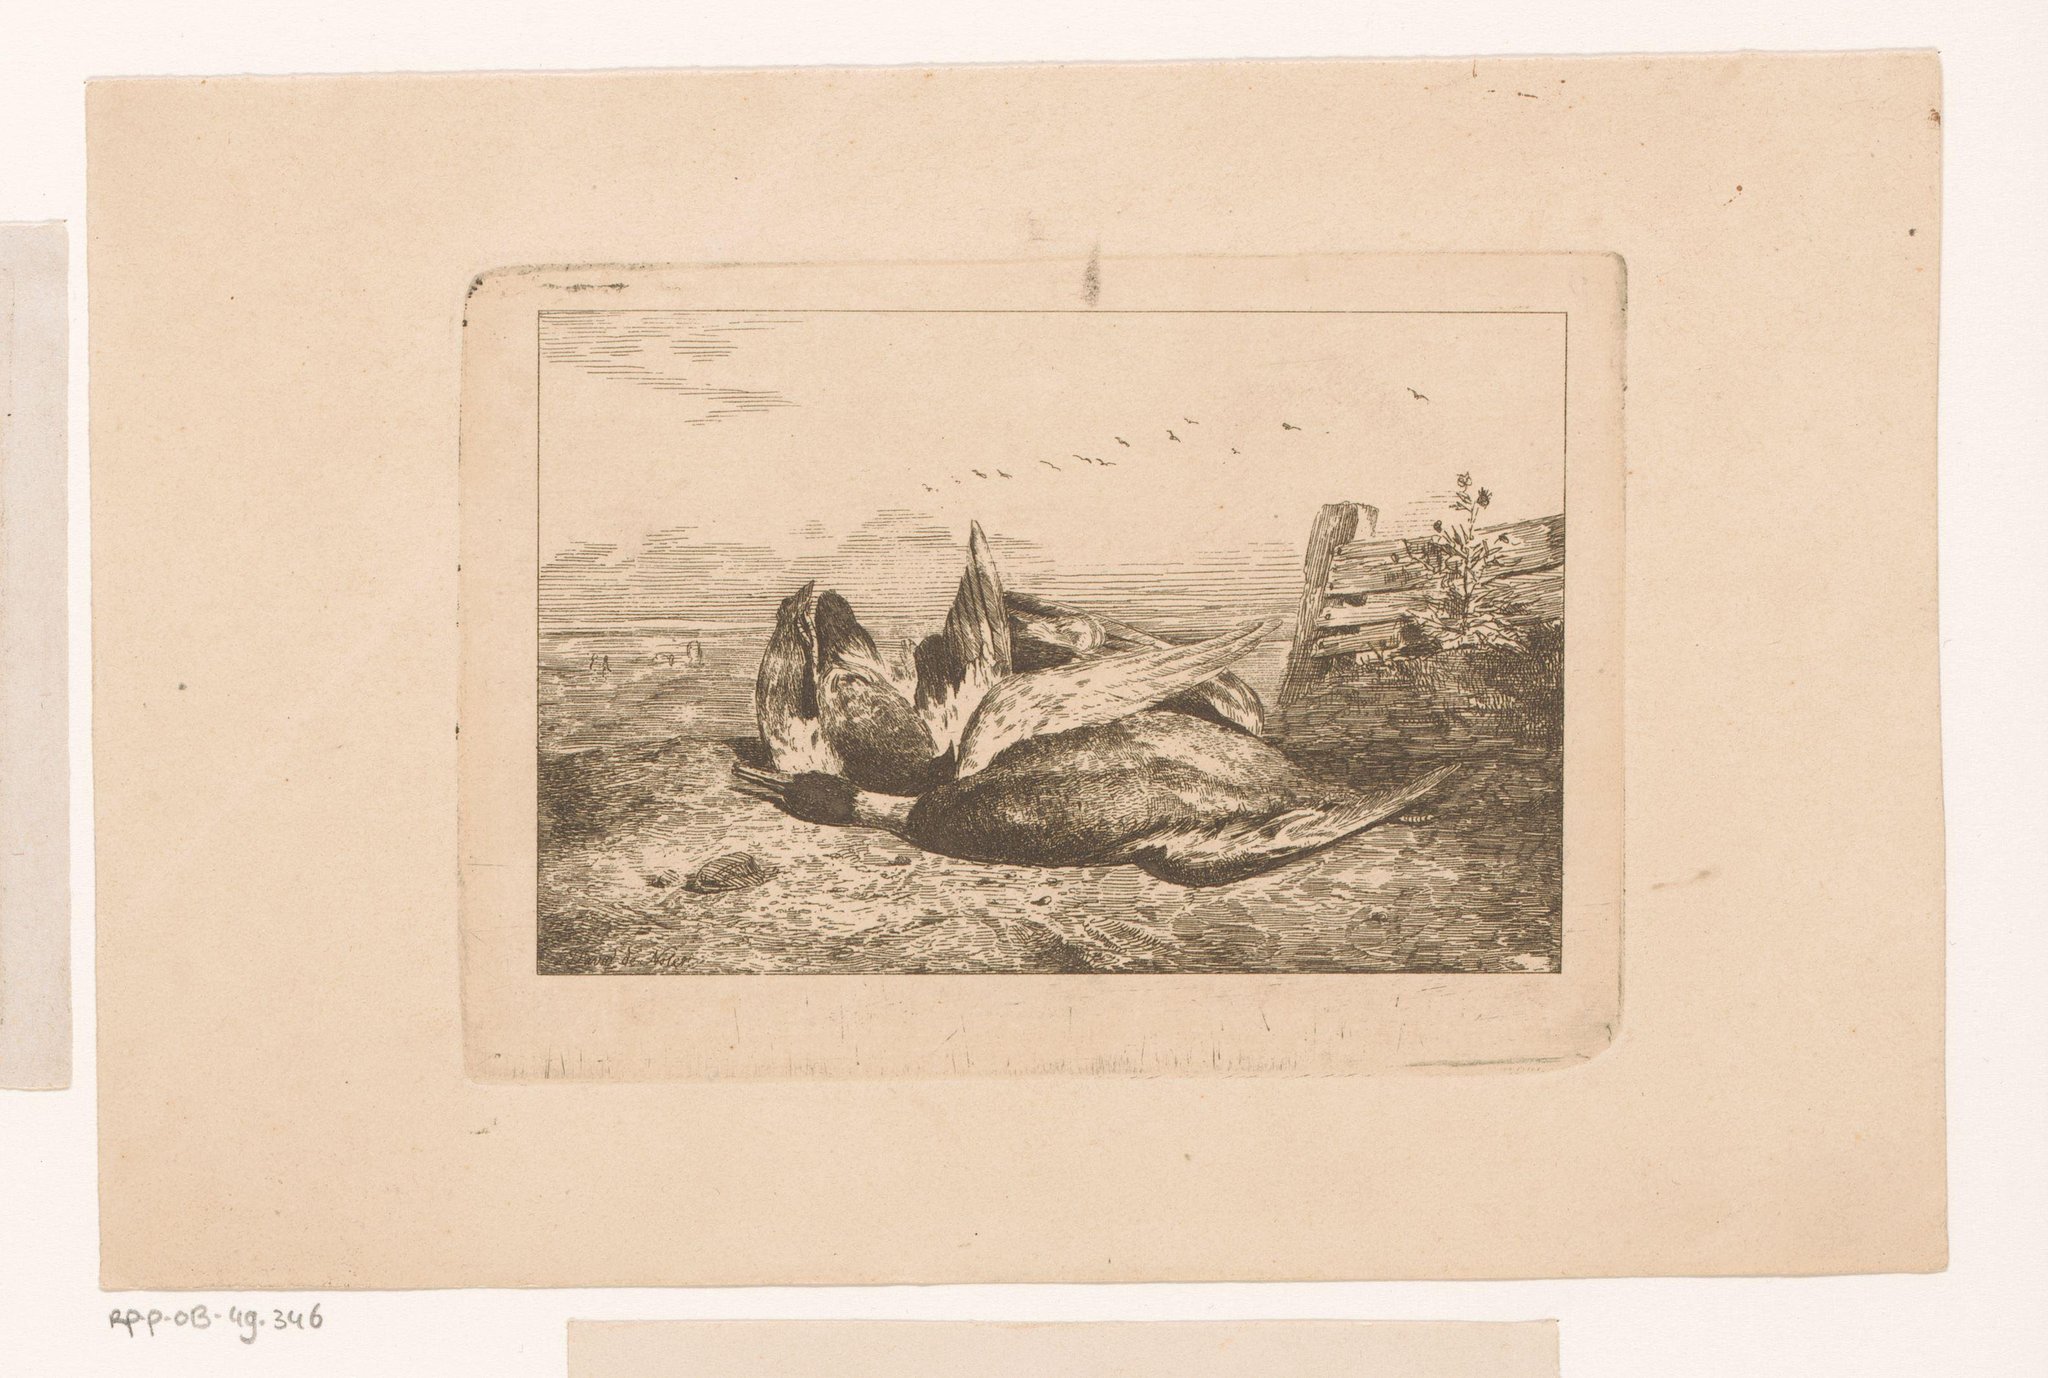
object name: print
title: Drie dode vogels in het landschap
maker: david emile joseph de noter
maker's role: painter, print maker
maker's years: 1818-1892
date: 1828-1879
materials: paper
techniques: etching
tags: landscapes, water-birds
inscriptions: collector's mark: Lugt 2228